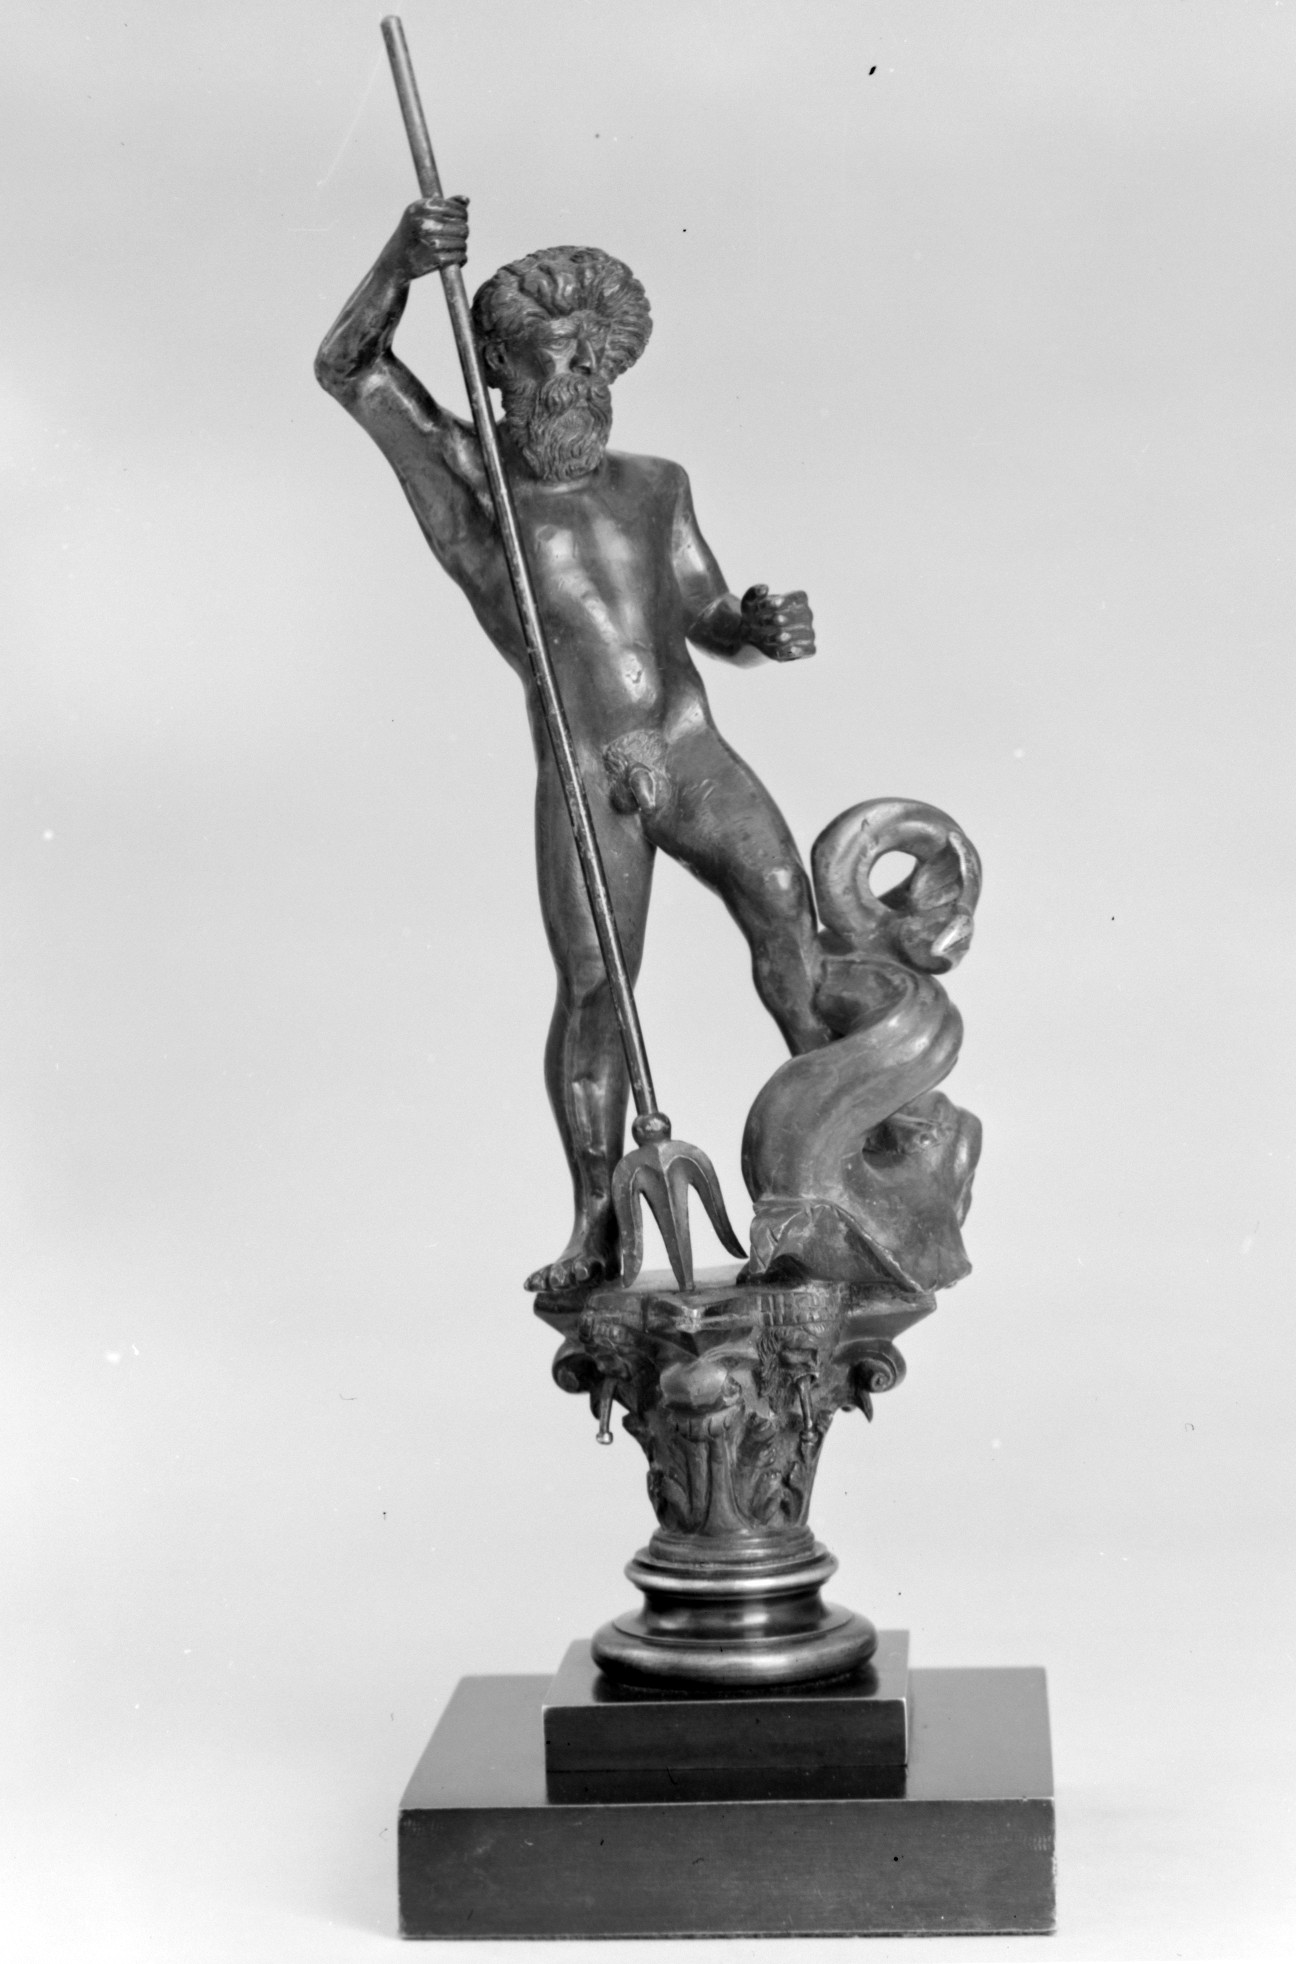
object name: fountain statuette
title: Neptune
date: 1534-1566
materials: bronze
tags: neptune